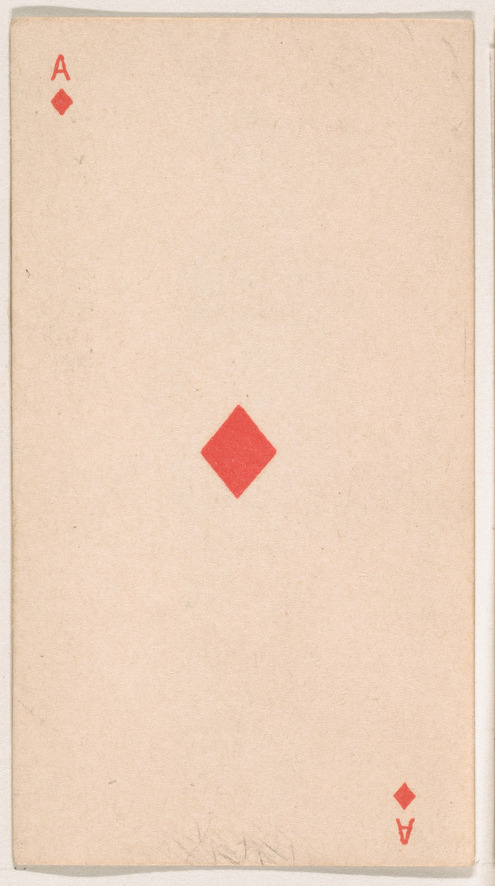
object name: print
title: Ace of Diamonds, from the Transparent Playing Cards series (N220) issued by Kinney Bros.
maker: kinney brothers tobacco company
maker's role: publisher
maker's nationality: american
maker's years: 1869-2011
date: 1888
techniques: color lithograph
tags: playing cards